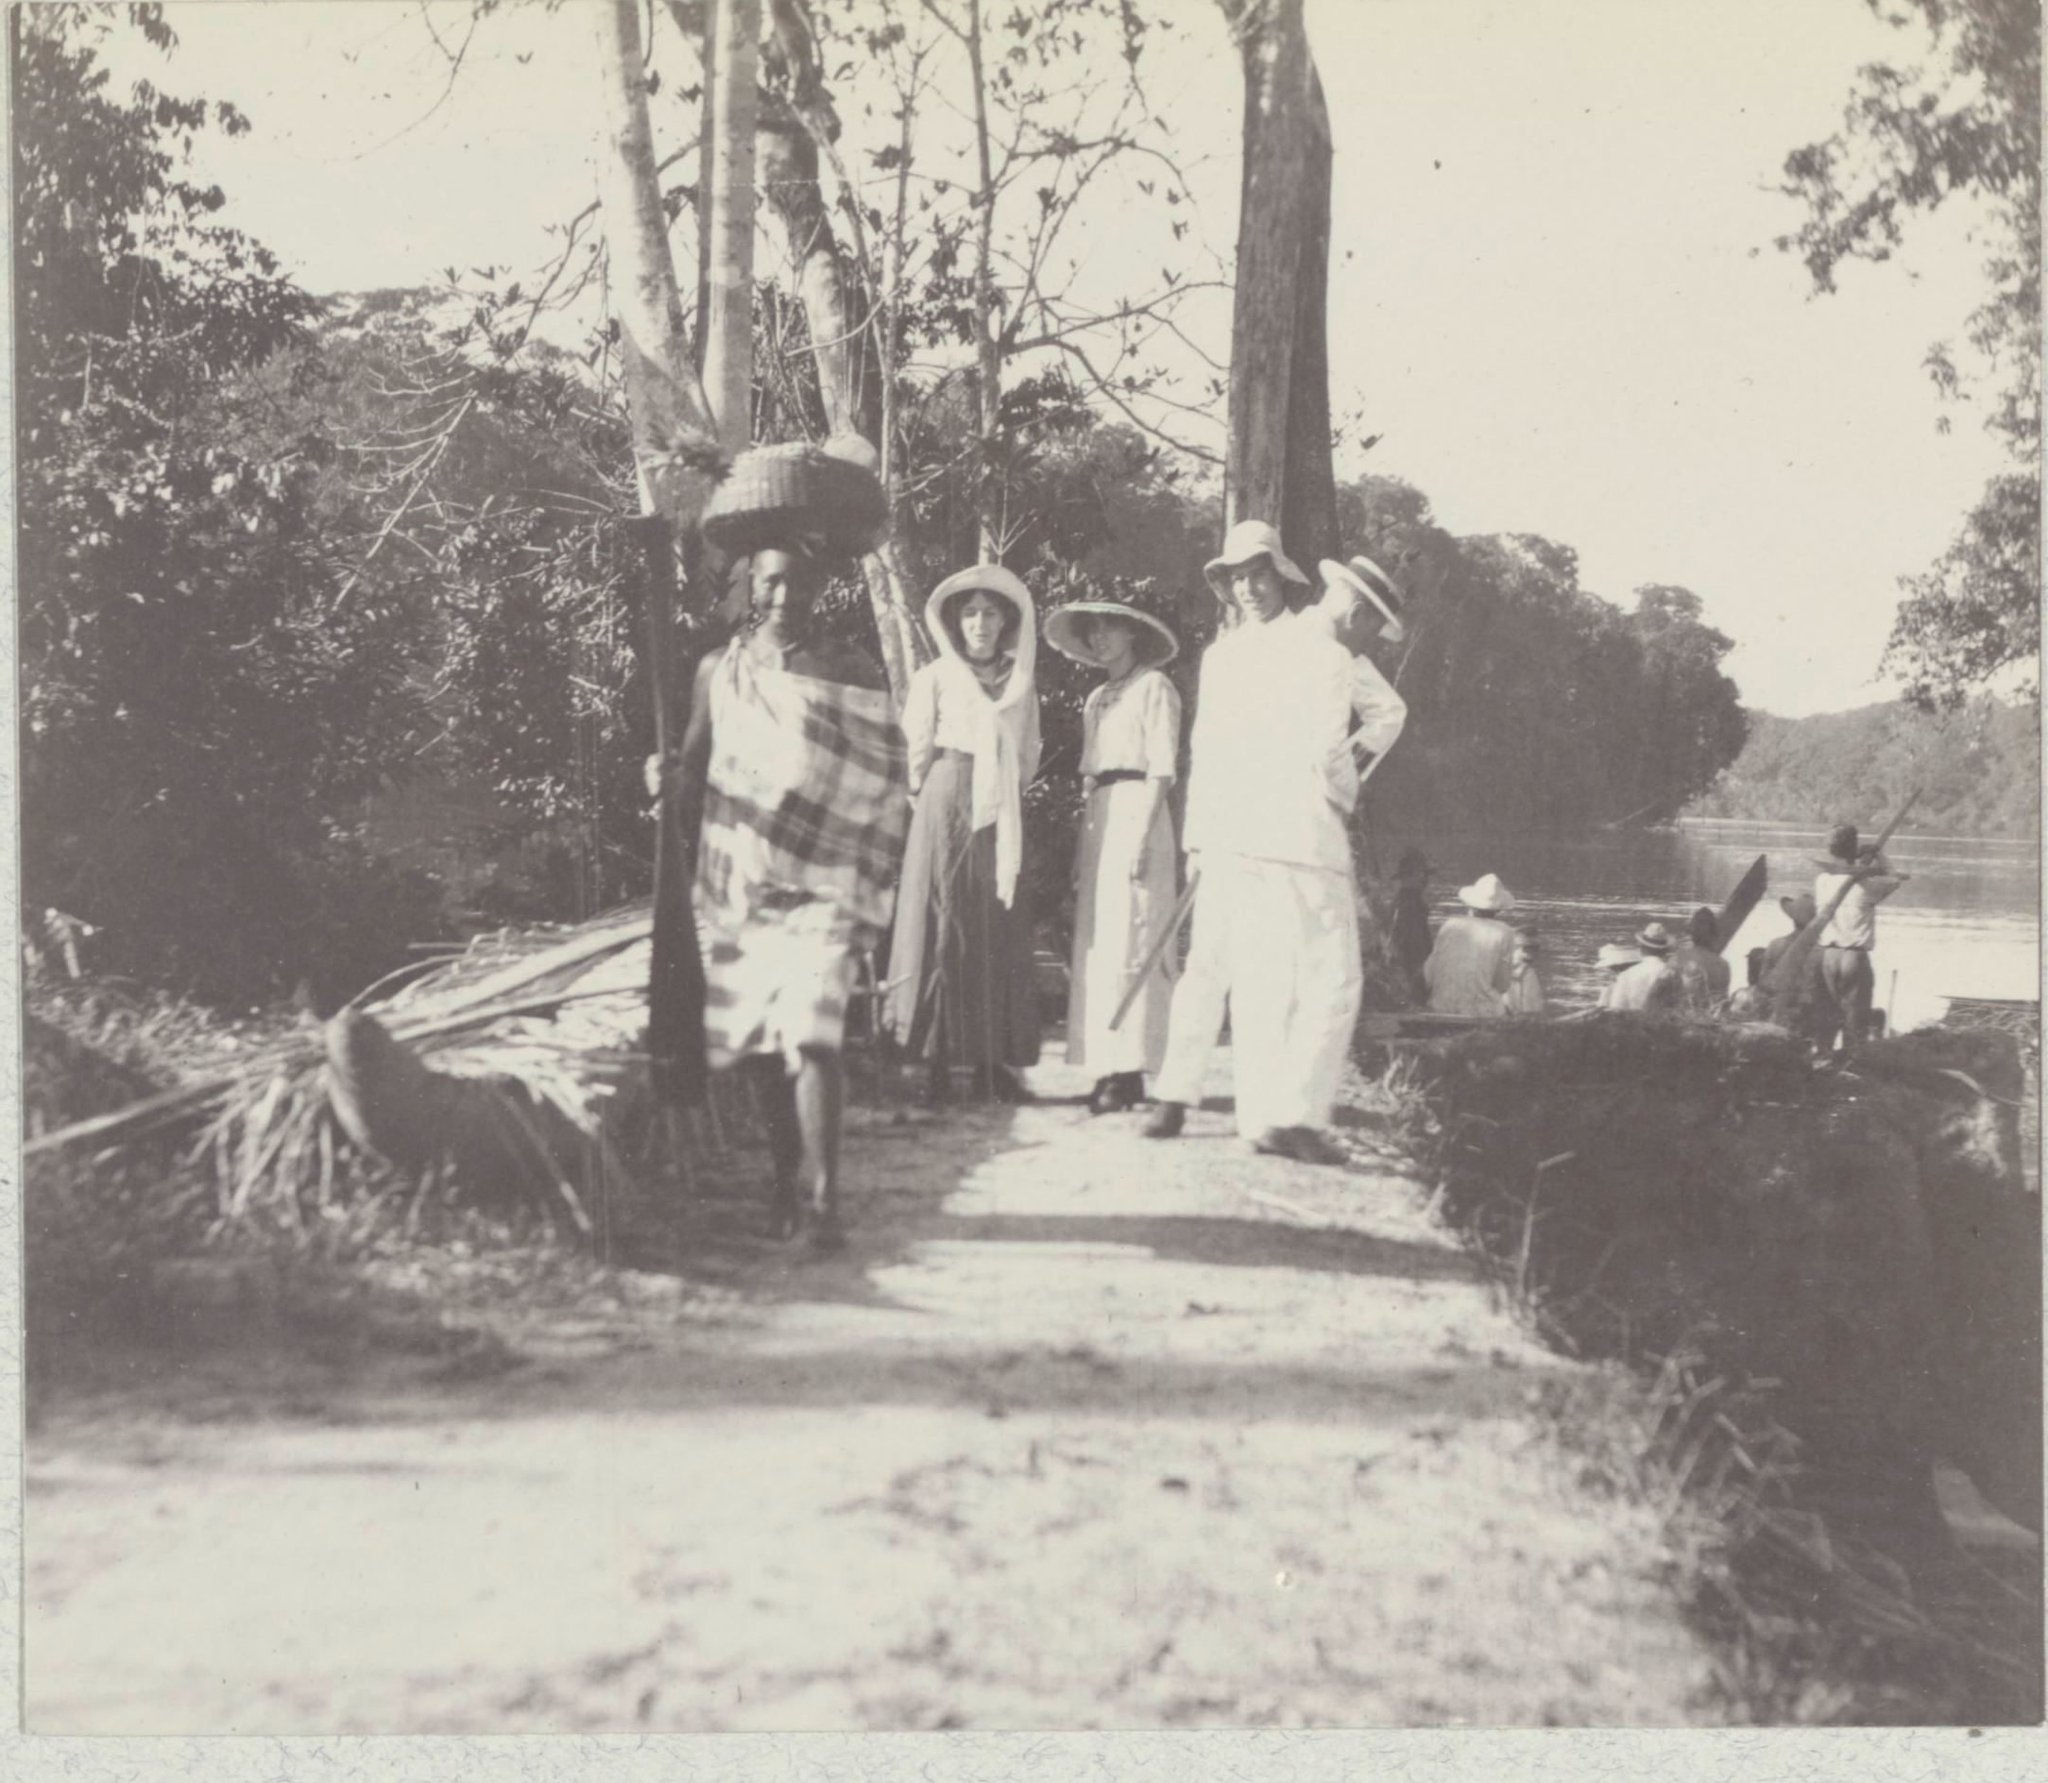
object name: photograph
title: Pad langs het water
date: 1911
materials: photographic support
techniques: photography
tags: suriname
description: Enkele Nederlanders, waaronder Maria Gonggrijp, op een pad langs een rivier. Aan het pad staat een Surinaamse vrouw met een mand op haar hoofd naast een kano, 1911. Onderdeel van het fotoalbum van de familie Boom-Gonggrijp in Suriname en Curaçao.